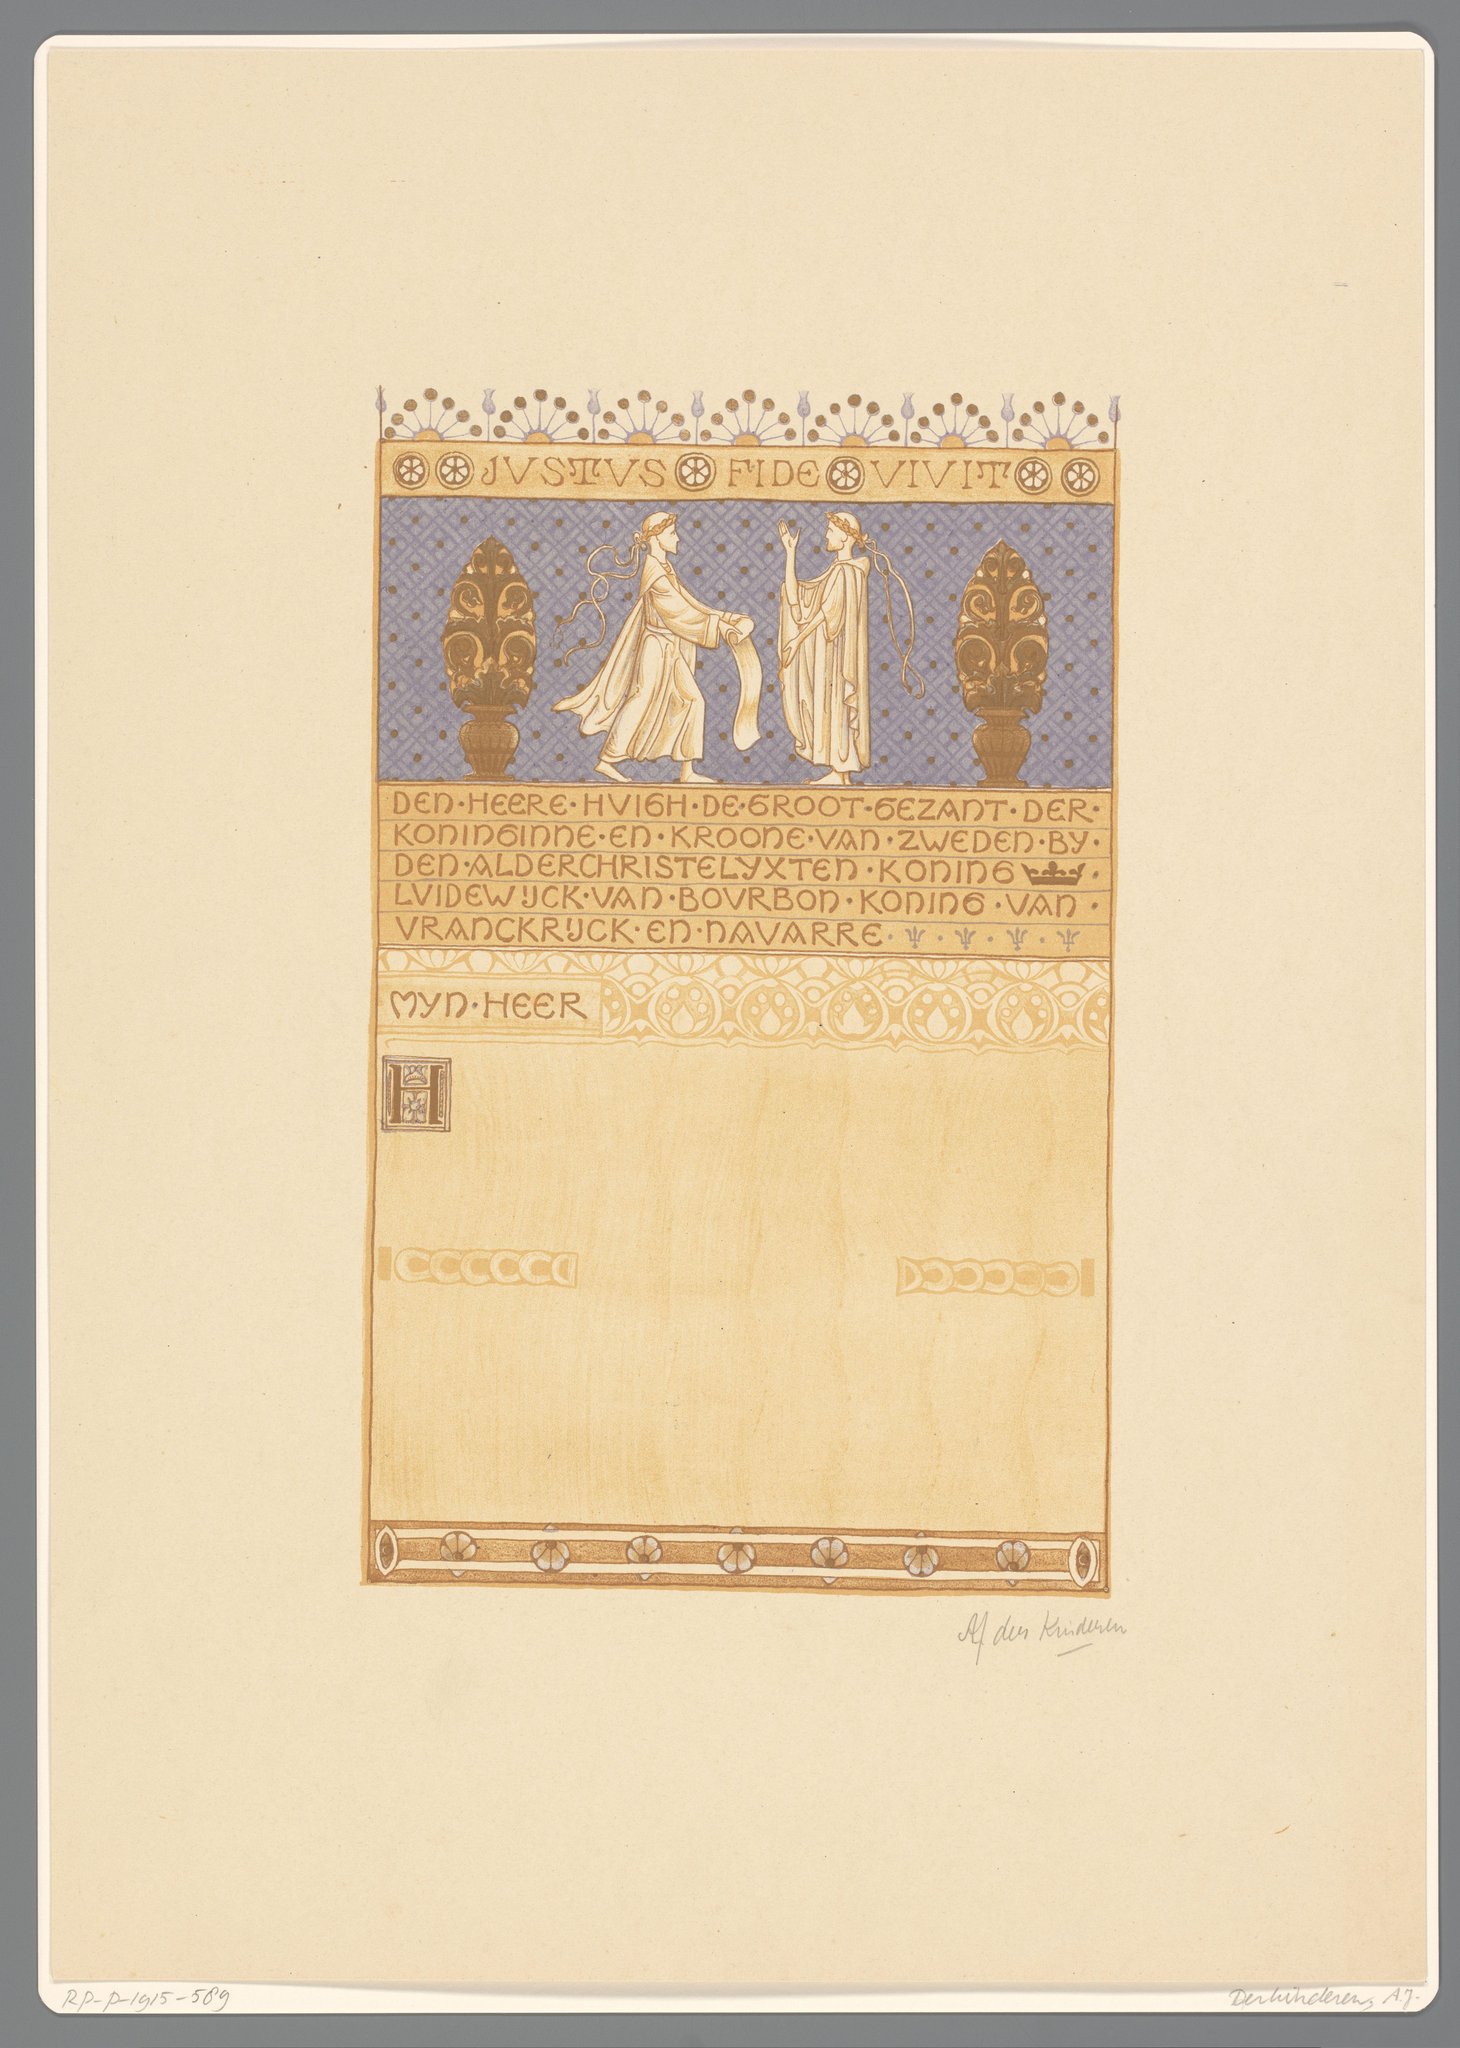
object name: print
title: Opdracht aan Hugo de Groot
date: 1894-1901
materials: paper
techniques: lithograph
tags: delft, hugo de groot, plants; vegetation, messenger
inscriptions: collector's mark: Lugt 2233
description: Twee mannen in een gewaad, van wie er één een rol perkament vasthoudt. Bovenaan de tekst 'justus fide vivit, onderaan meer tekst en ruimte voor tekst. Om het geheel een sierrand met bloem- en plantmotieven. Eerste pagina.